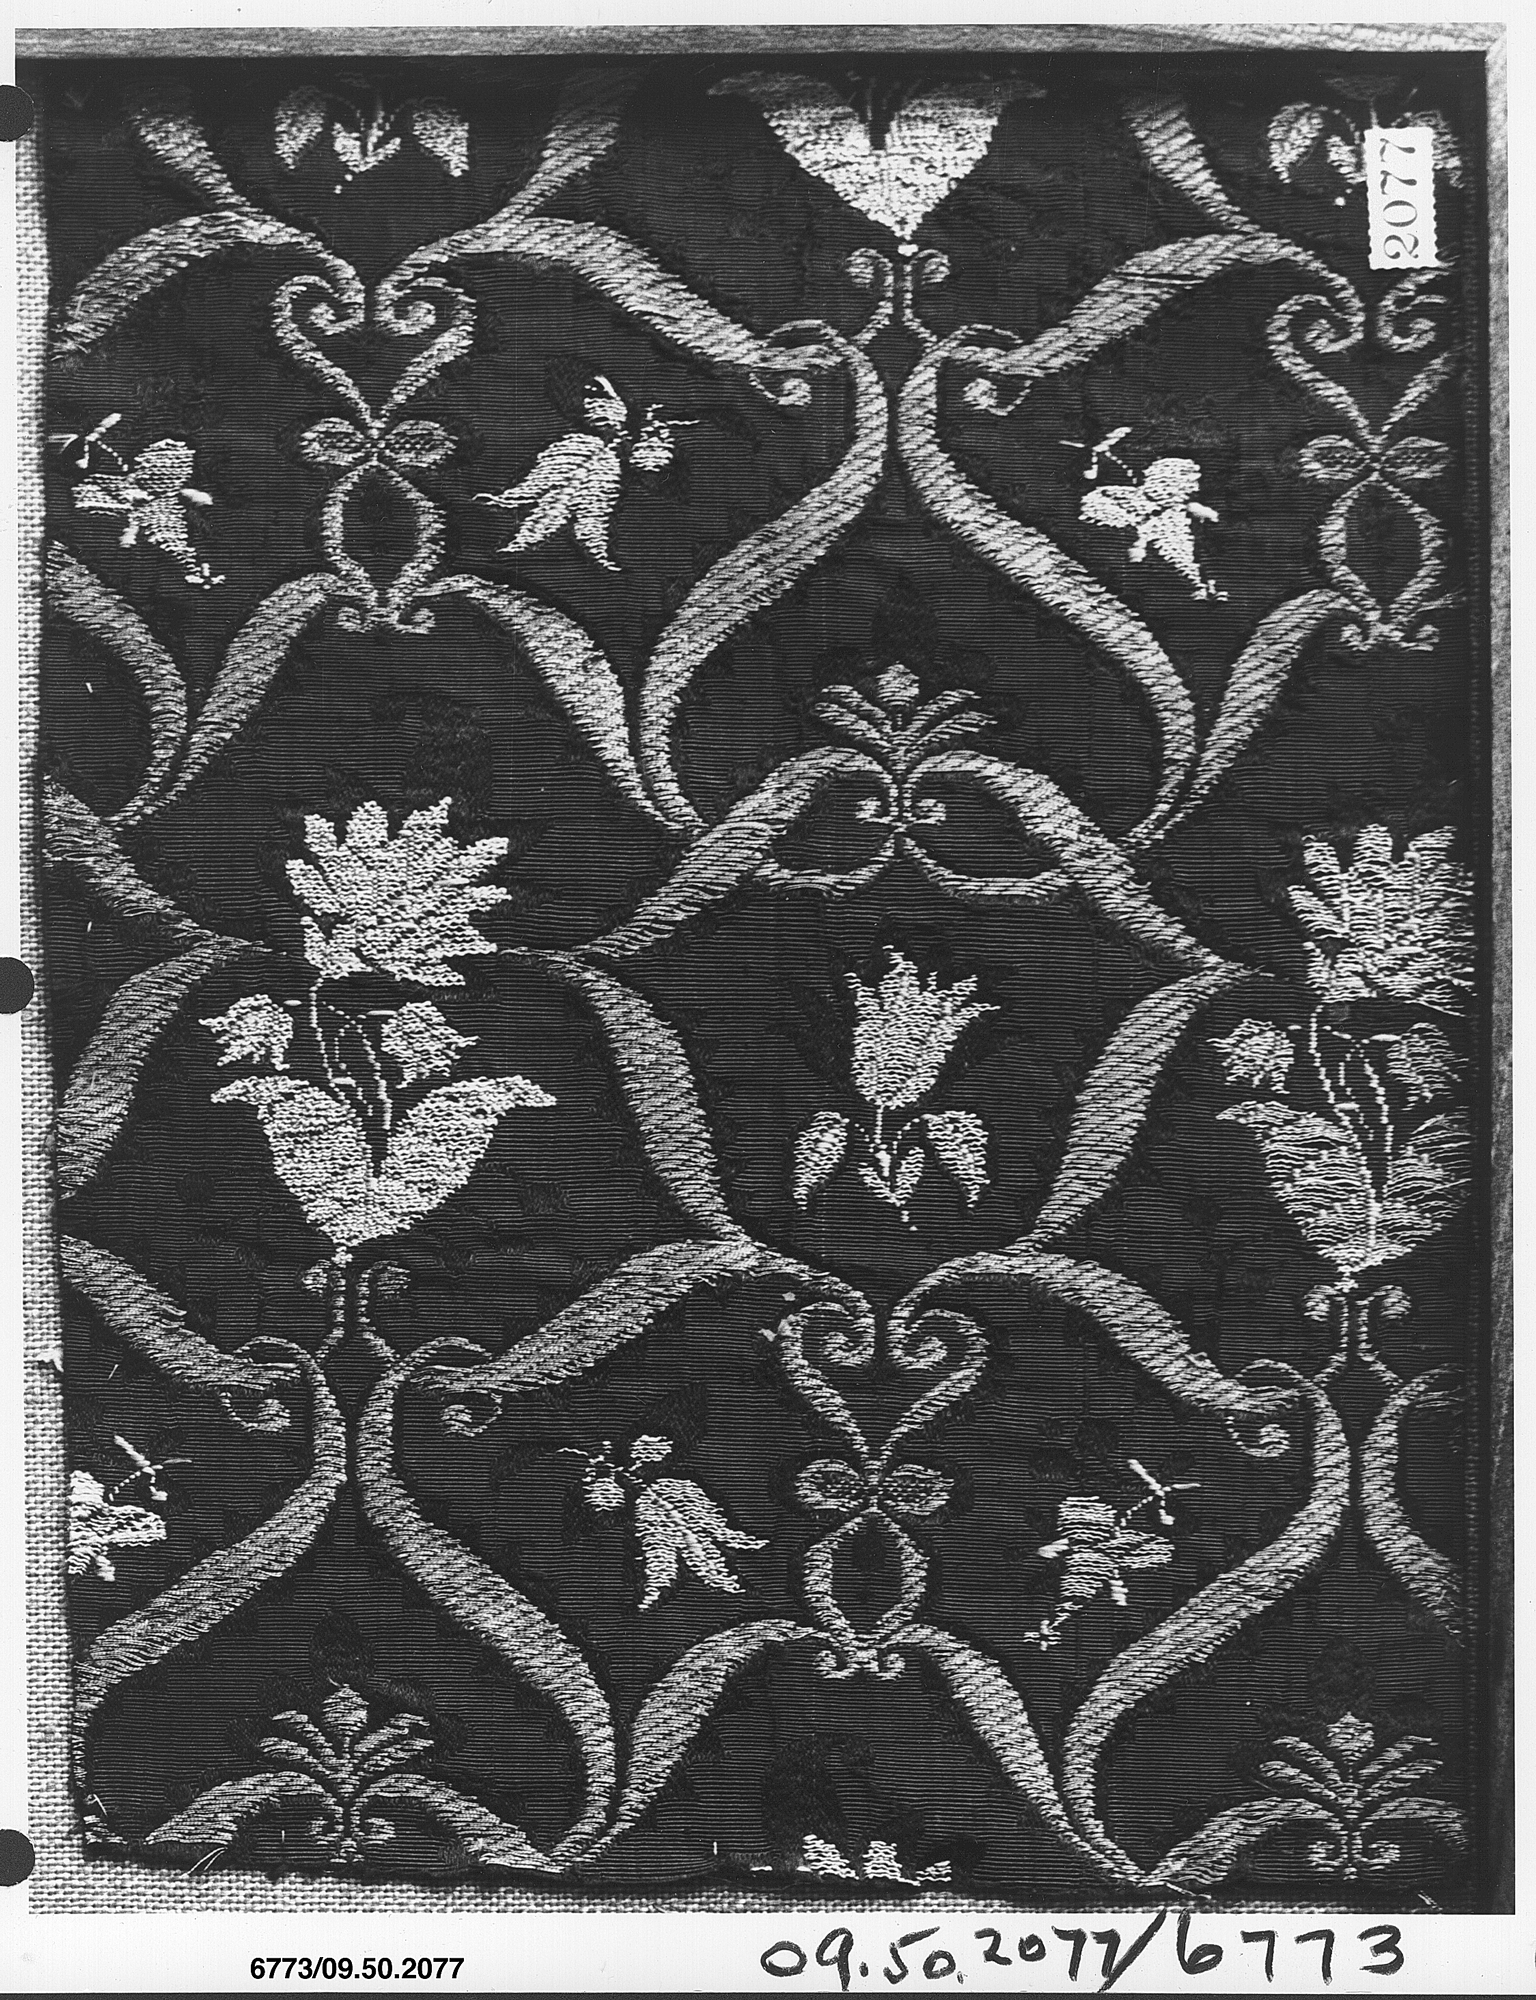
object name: piece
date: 1701-1733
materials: metal thread, silk